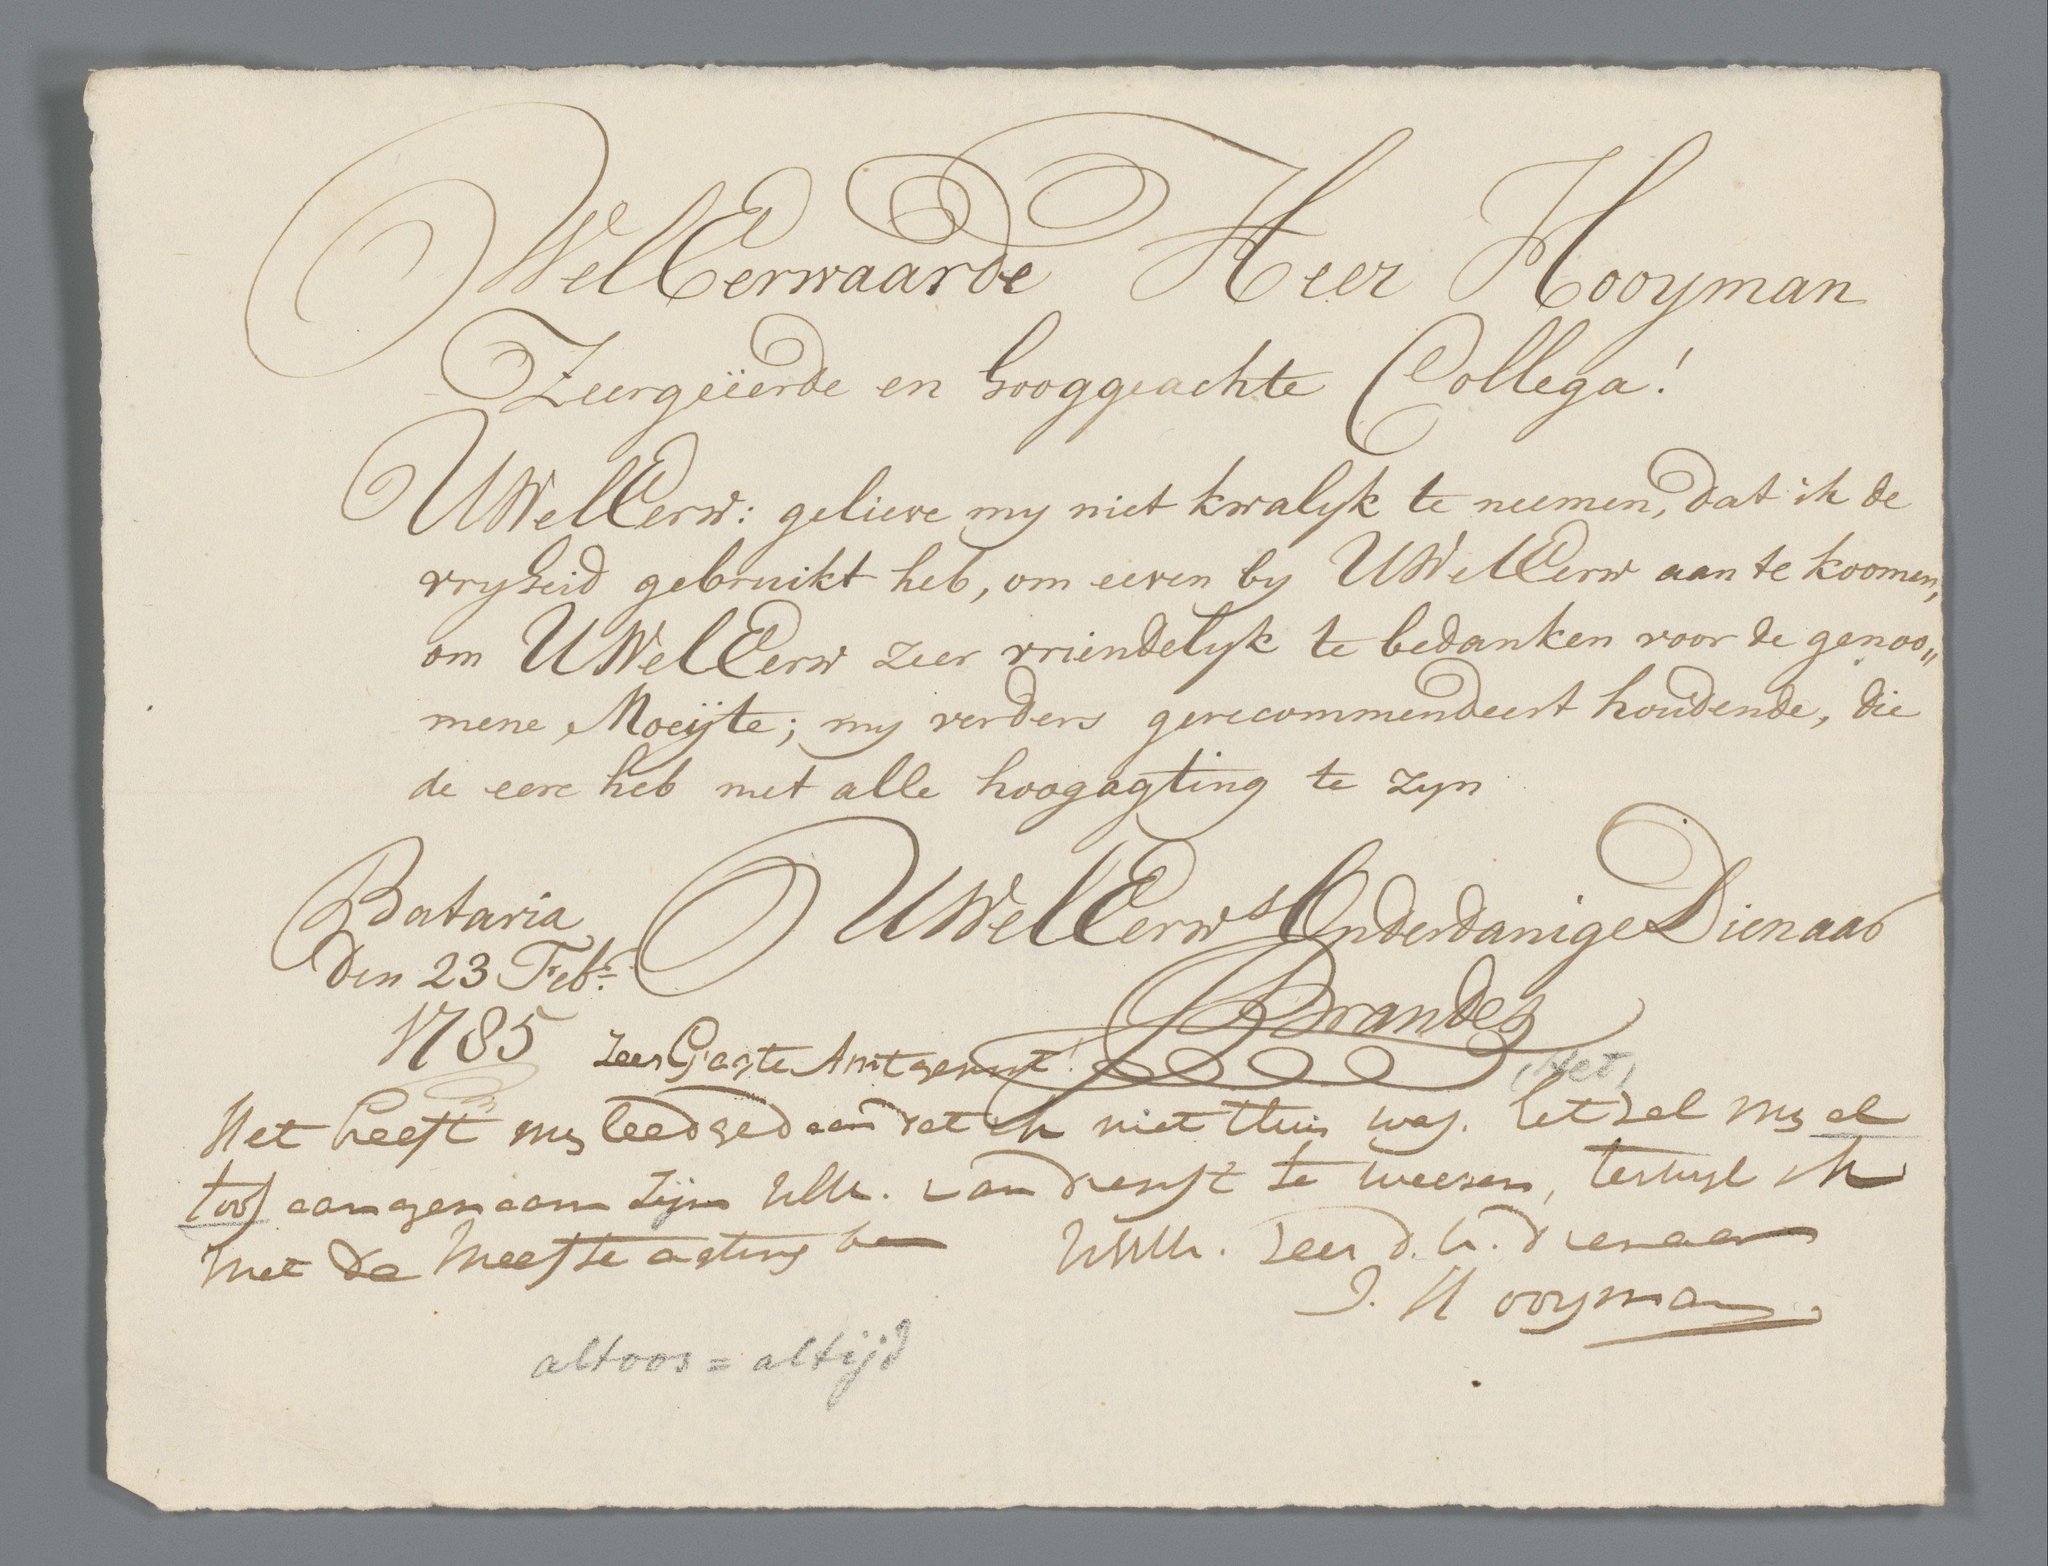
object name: letter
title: Brief van Jan Brandes aan ds. Hooyman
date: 1785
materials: ink, paper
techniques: pen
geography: batavia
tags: bodegraven, draughtsman, jan brandes, batavia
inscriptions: date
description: Briefje van Jan Brandes aan predikant Johannes Hooyman waarin hij aangeeft hem bij een bezoek op 23 februari 1785 niet thuis te hebben aangetroffen, met antwoord van Hooyman waarin hij aangeeft het jammer te vinden dat hij niet thuis was. Onderdeel van een groep papieren van Jan Brandes uit zijn tijd als predikant bij de lutherse kerk te Batavia 1779-1785.